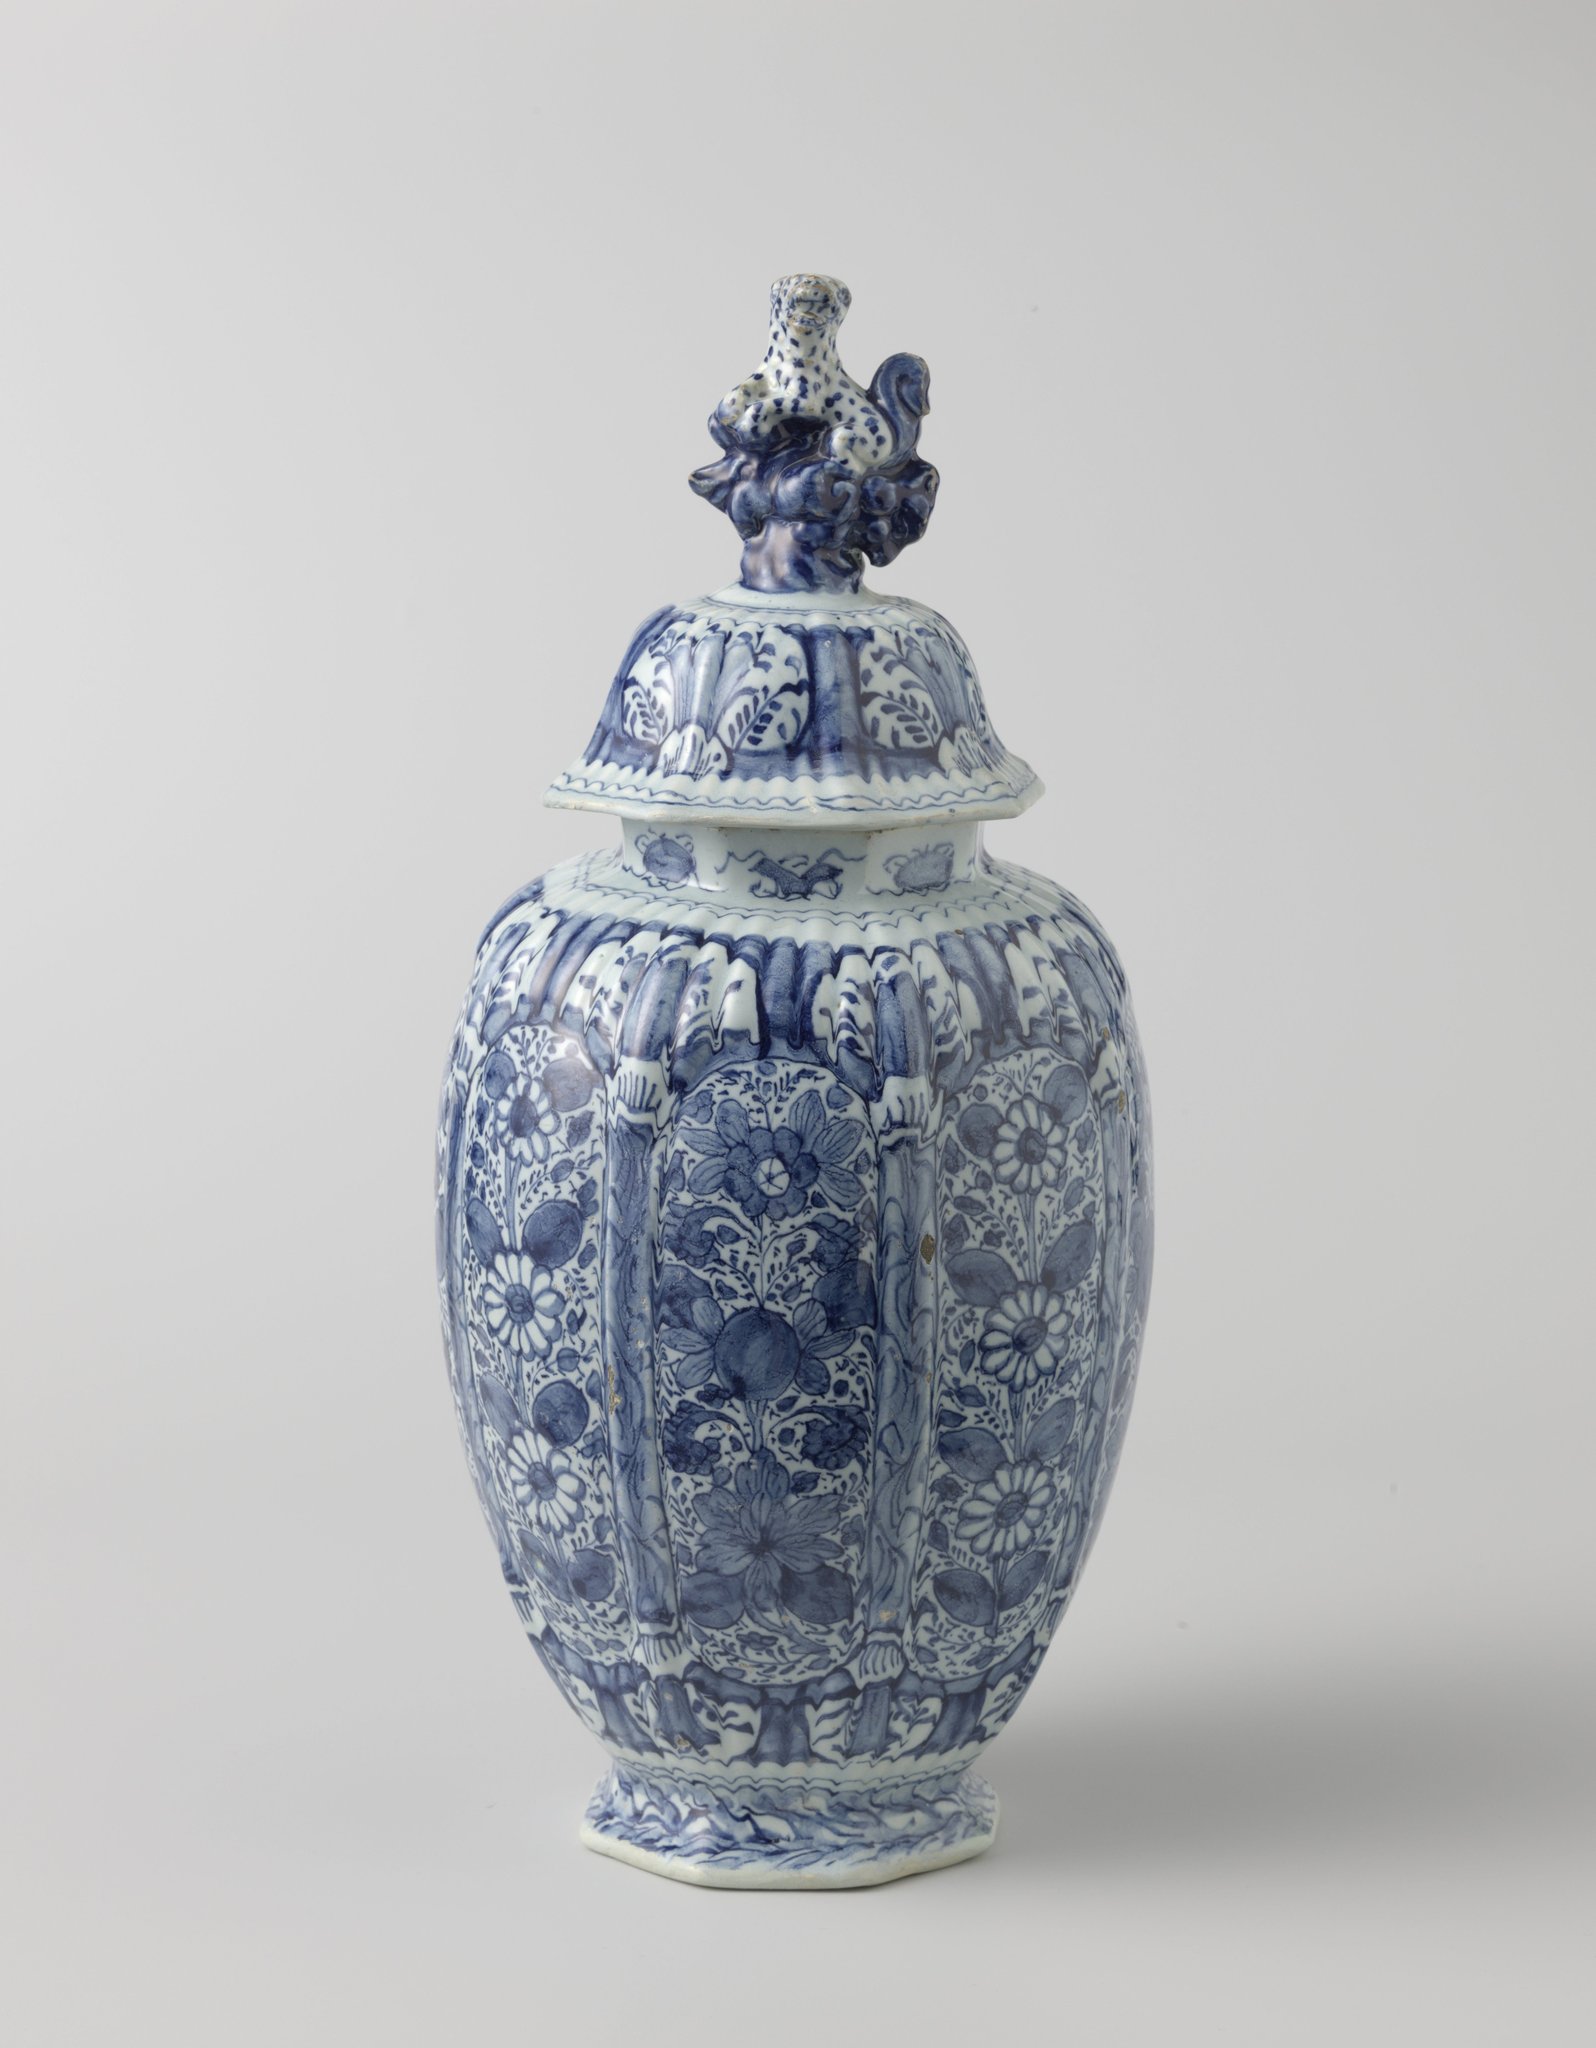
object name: kaststel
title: Pot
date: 1740-1780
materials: faience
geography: delft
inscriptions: mark: ‘LPK’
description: Deksel van pot van faience. Blauw beschilderd met bloemendecoraties. De pot is onderdeel van een kaststel.